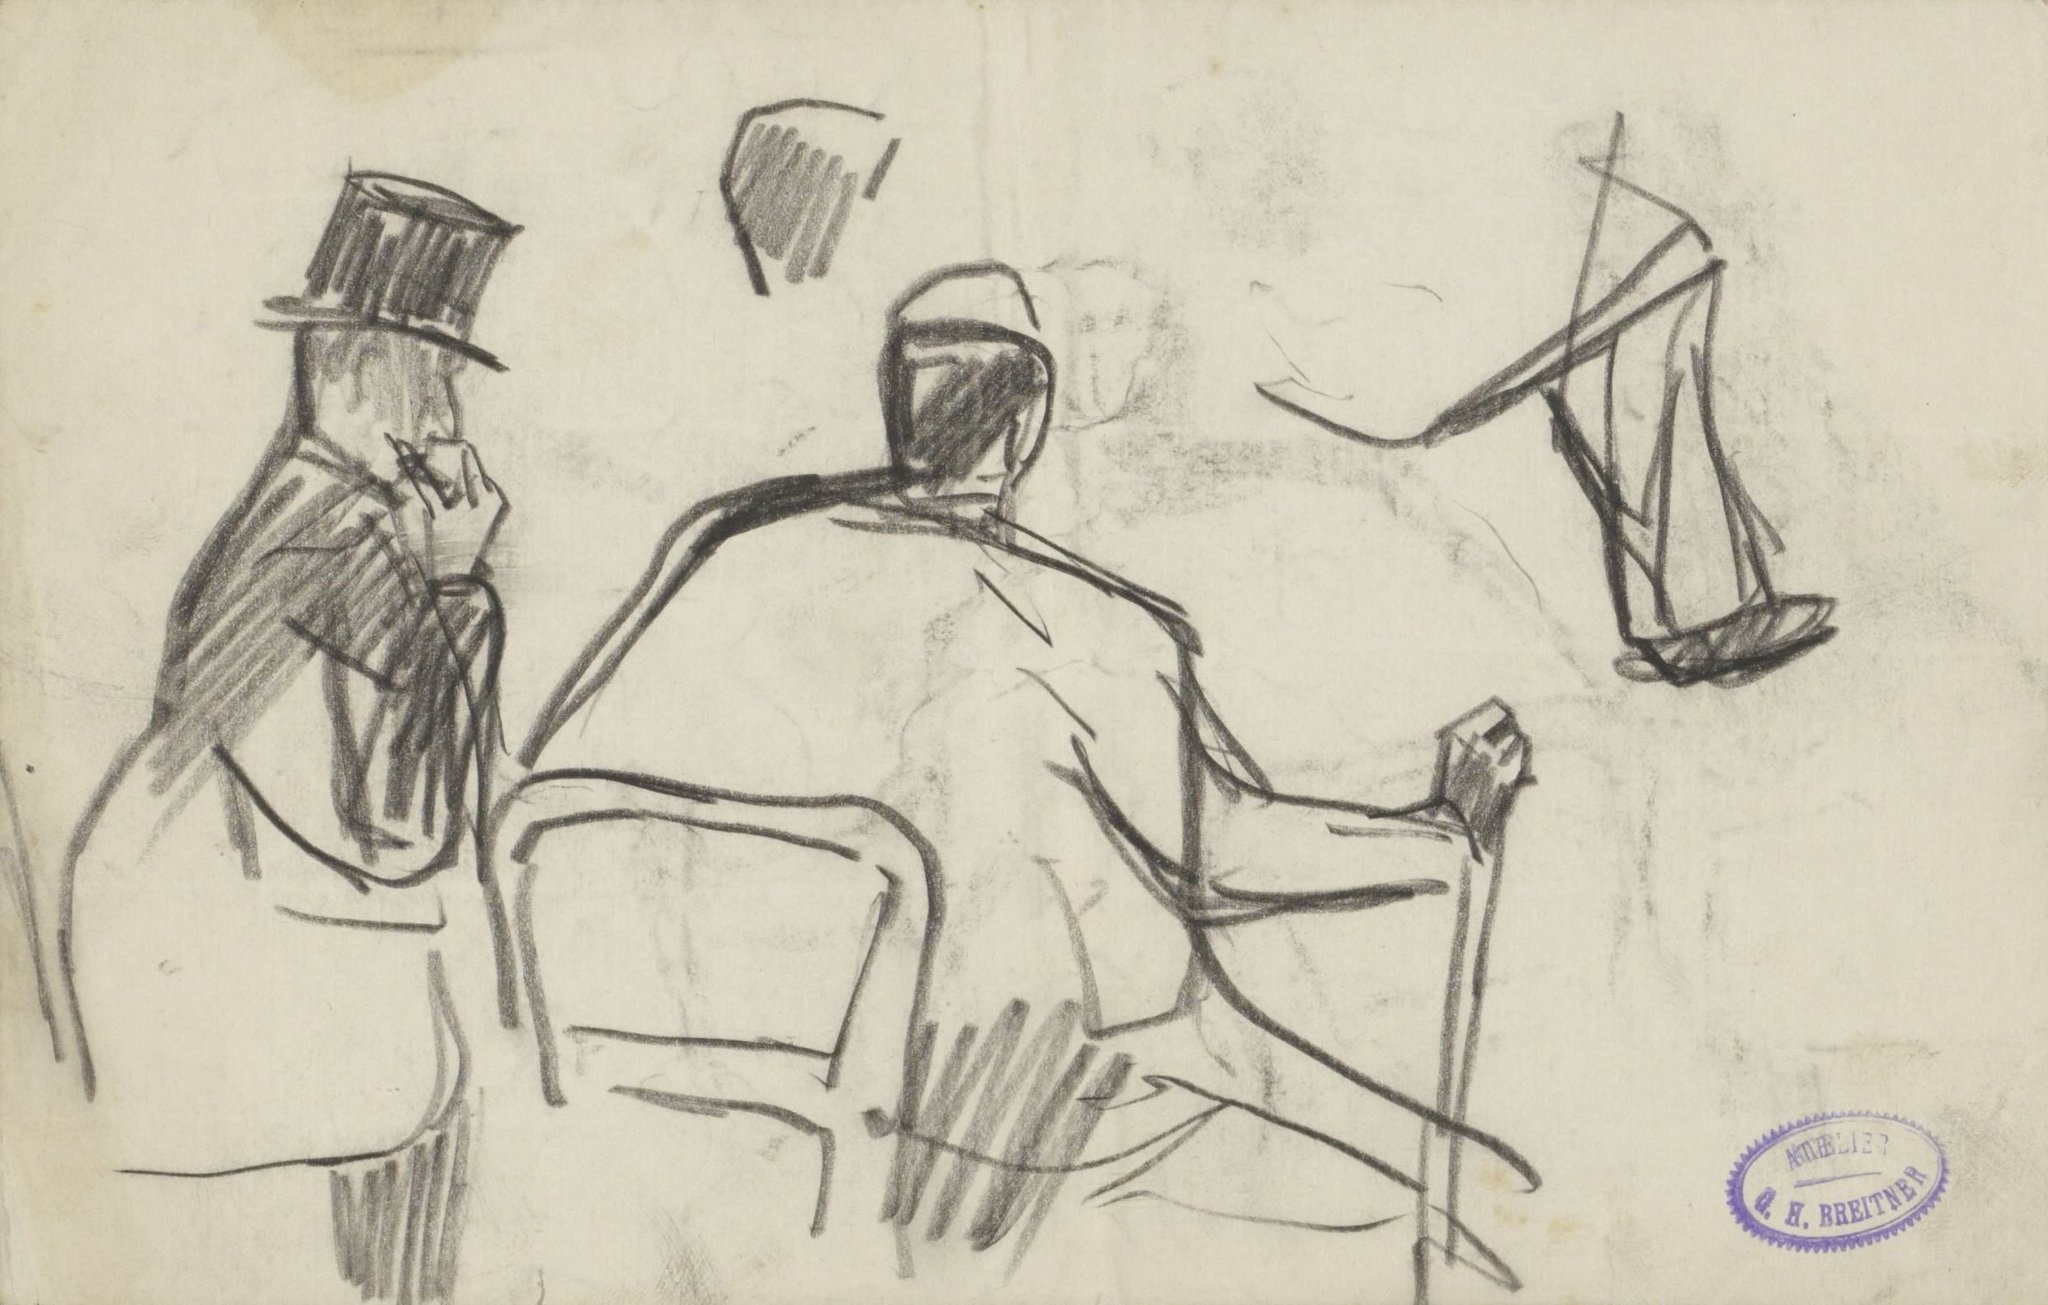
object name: drawing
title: Zittende mannen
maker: george hendrik breitner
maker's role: draughtsman, painter, print maker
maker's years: 1857-1923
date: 1896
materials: chalk, paper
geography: the hague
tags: adult man (+ sitting), sitting on an elevation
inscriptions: collector's mark: Lugt 2228, workshop stamp: Lugt 291d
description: Links een man met een hoge hoed en rechts een man met stok.